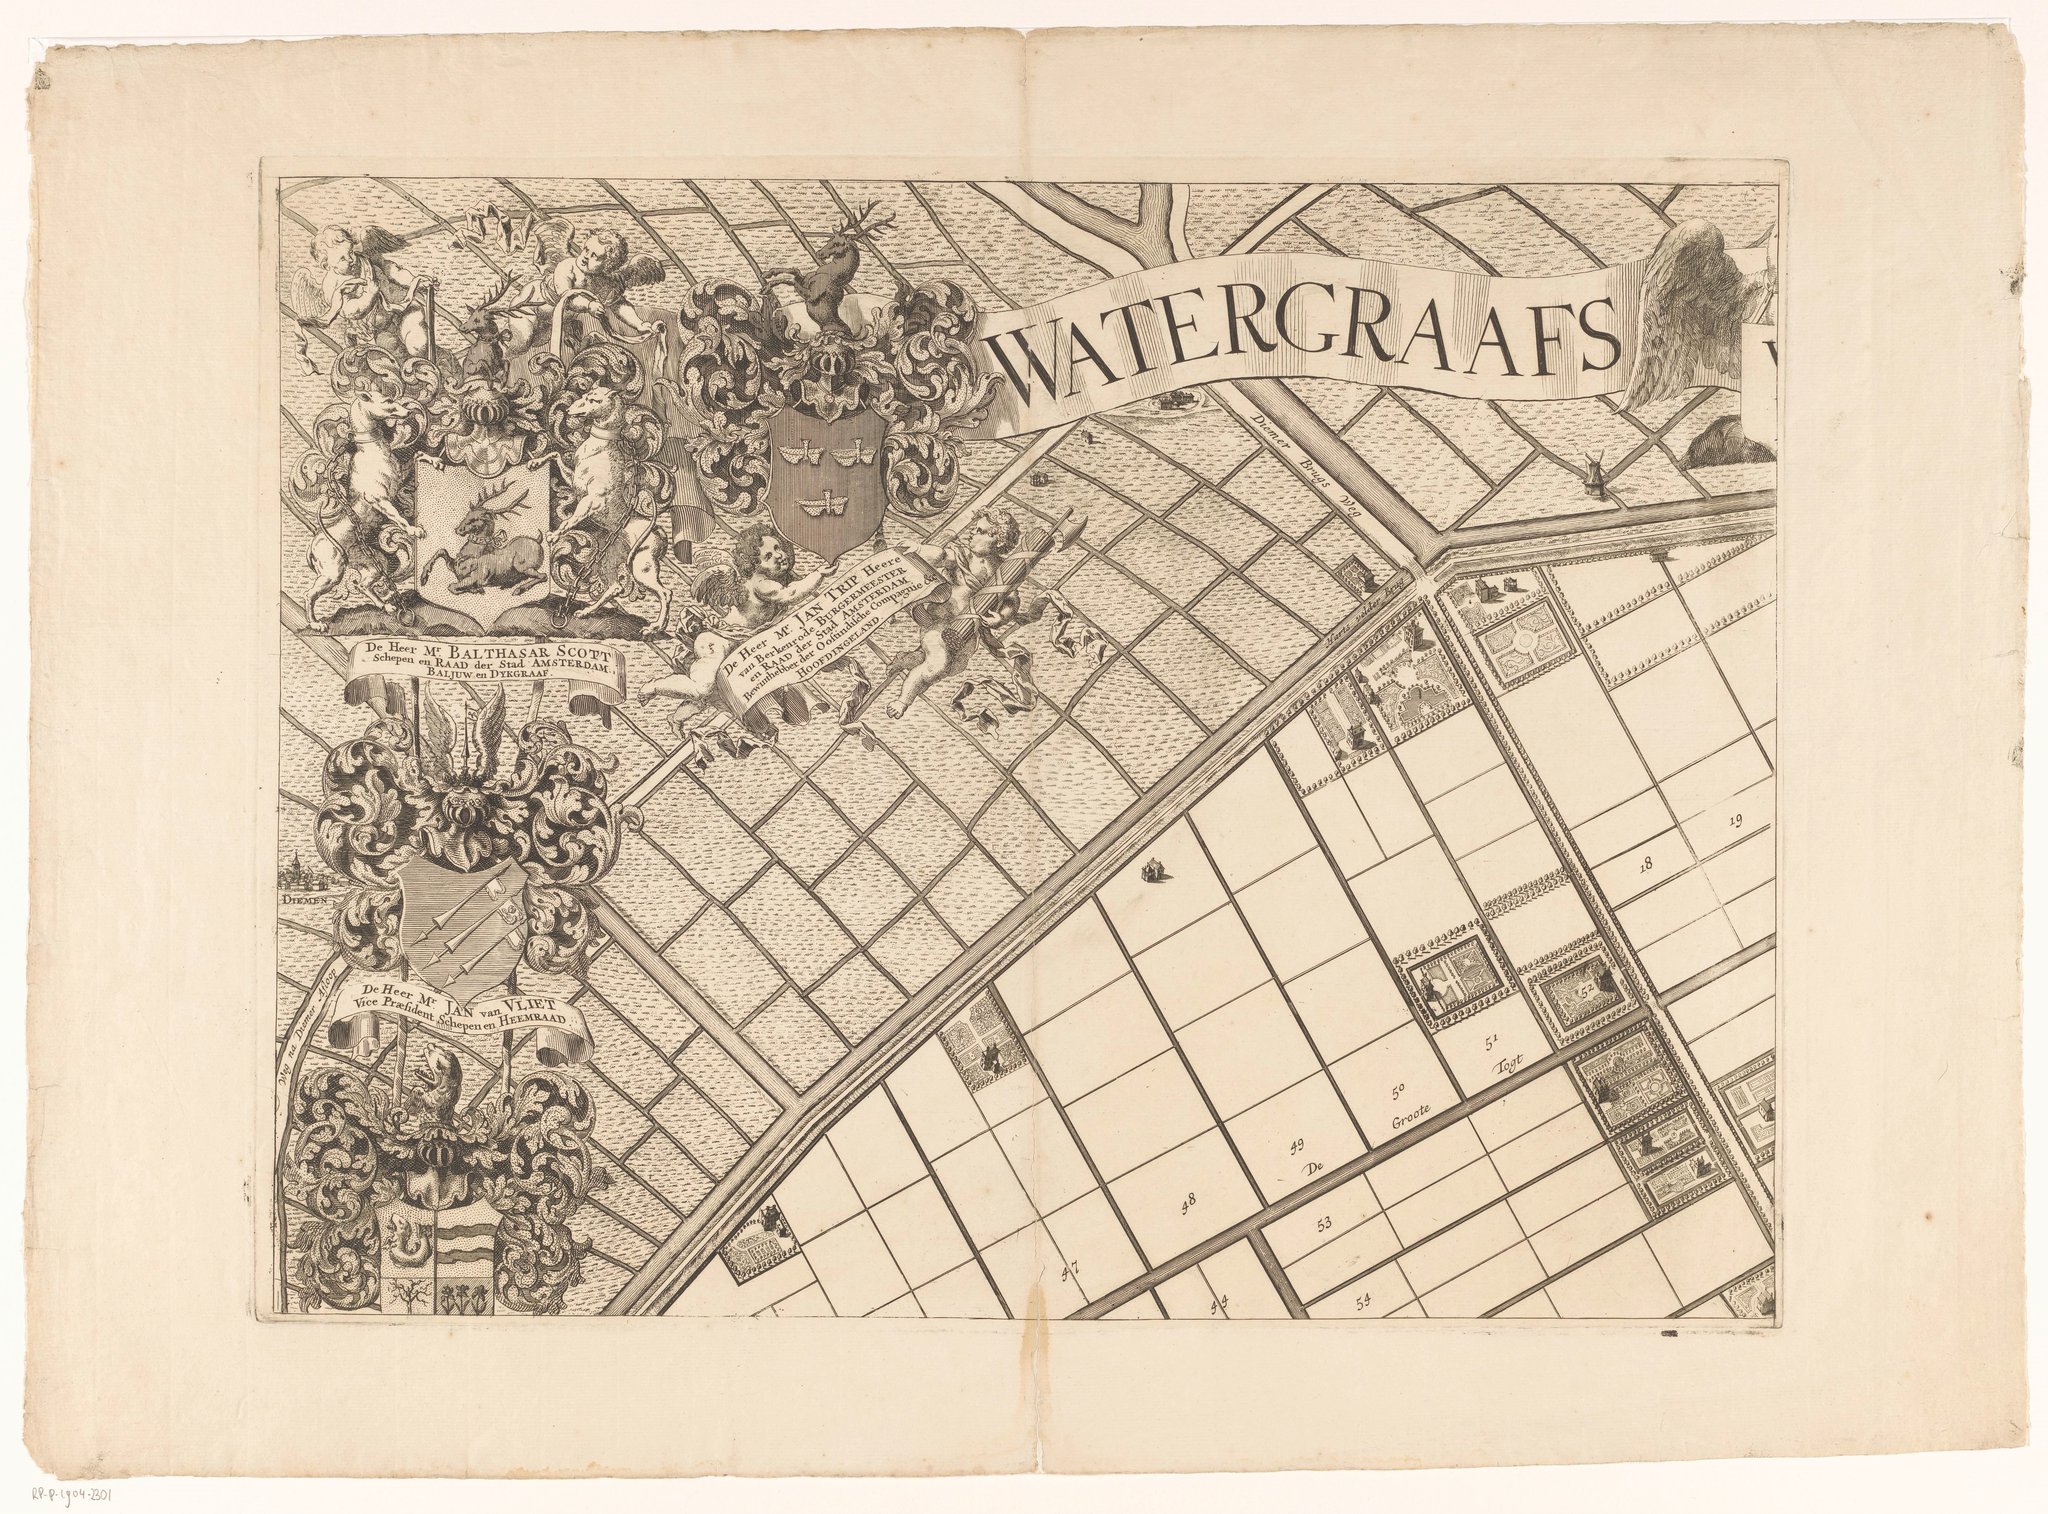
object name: map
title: Watergraafs of Diemer-meer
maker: pieter van den berge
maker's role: draughtsman, print maker, printer, publisher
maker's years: 1659-1737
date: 1719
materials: paper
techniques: engraving, etching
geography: amsterdam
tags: coat of arms (as symbol of the state, etc.), maps of separate countries or regions, polder, reclaimed land, armorial bearing, heraldry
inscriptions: collector's mark: Lugt 2228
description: Deel (linksboven) van een kaart van de Watergraafsmeer.